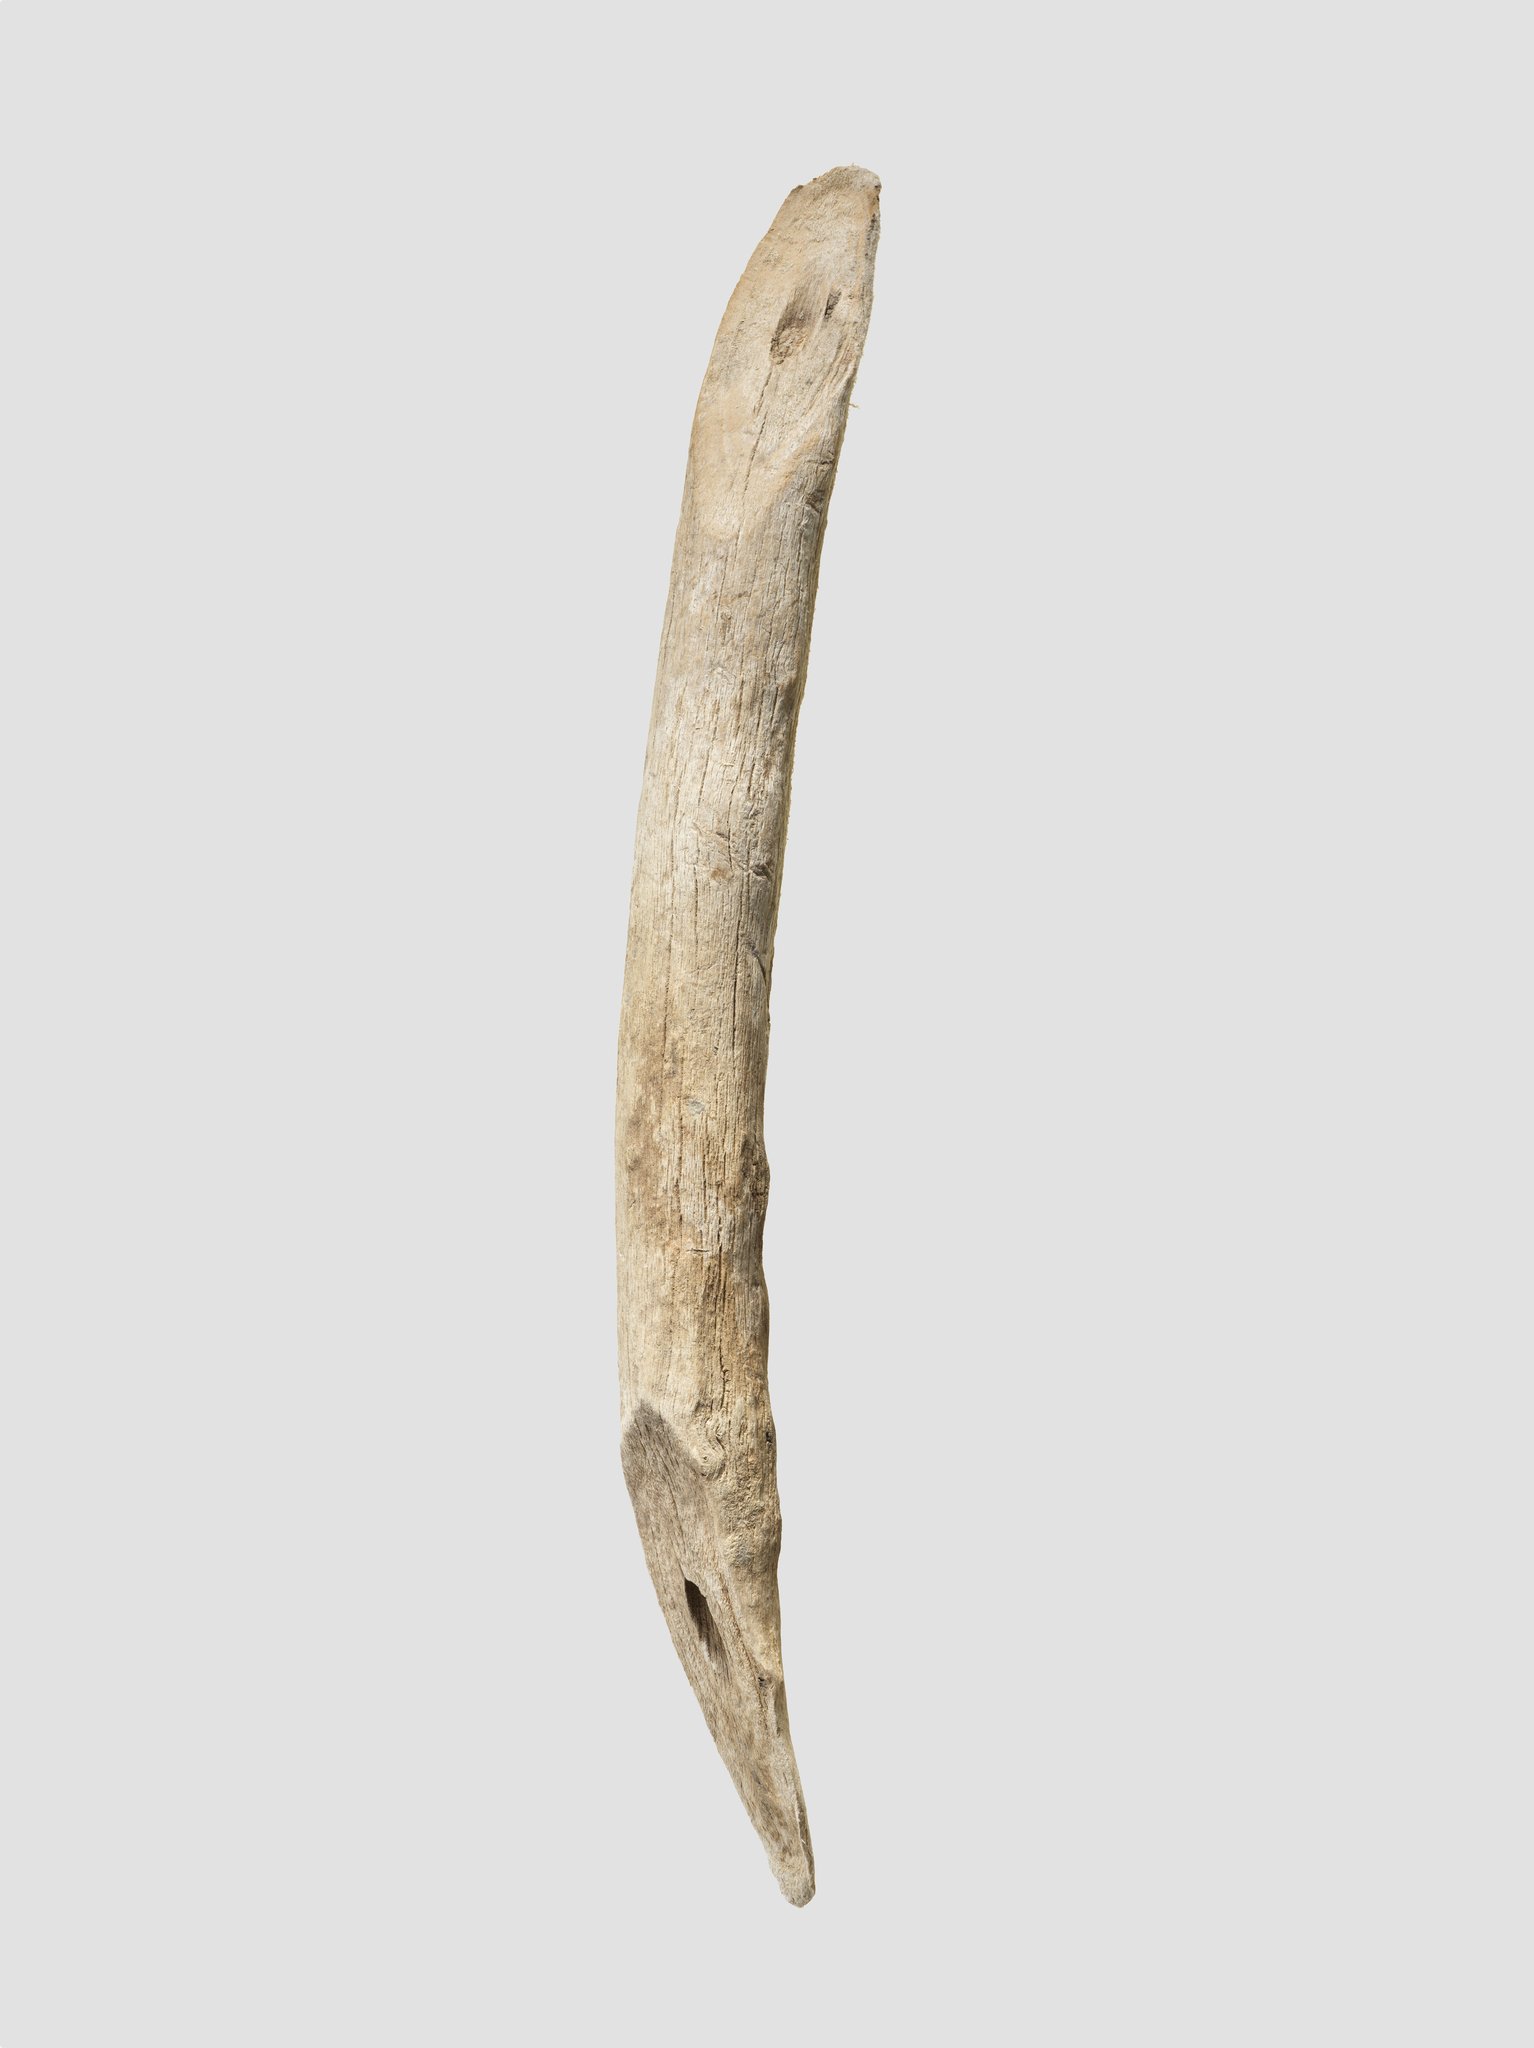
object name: handle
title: Curved handle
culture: alanic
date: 601-900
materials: wood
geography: caucasus